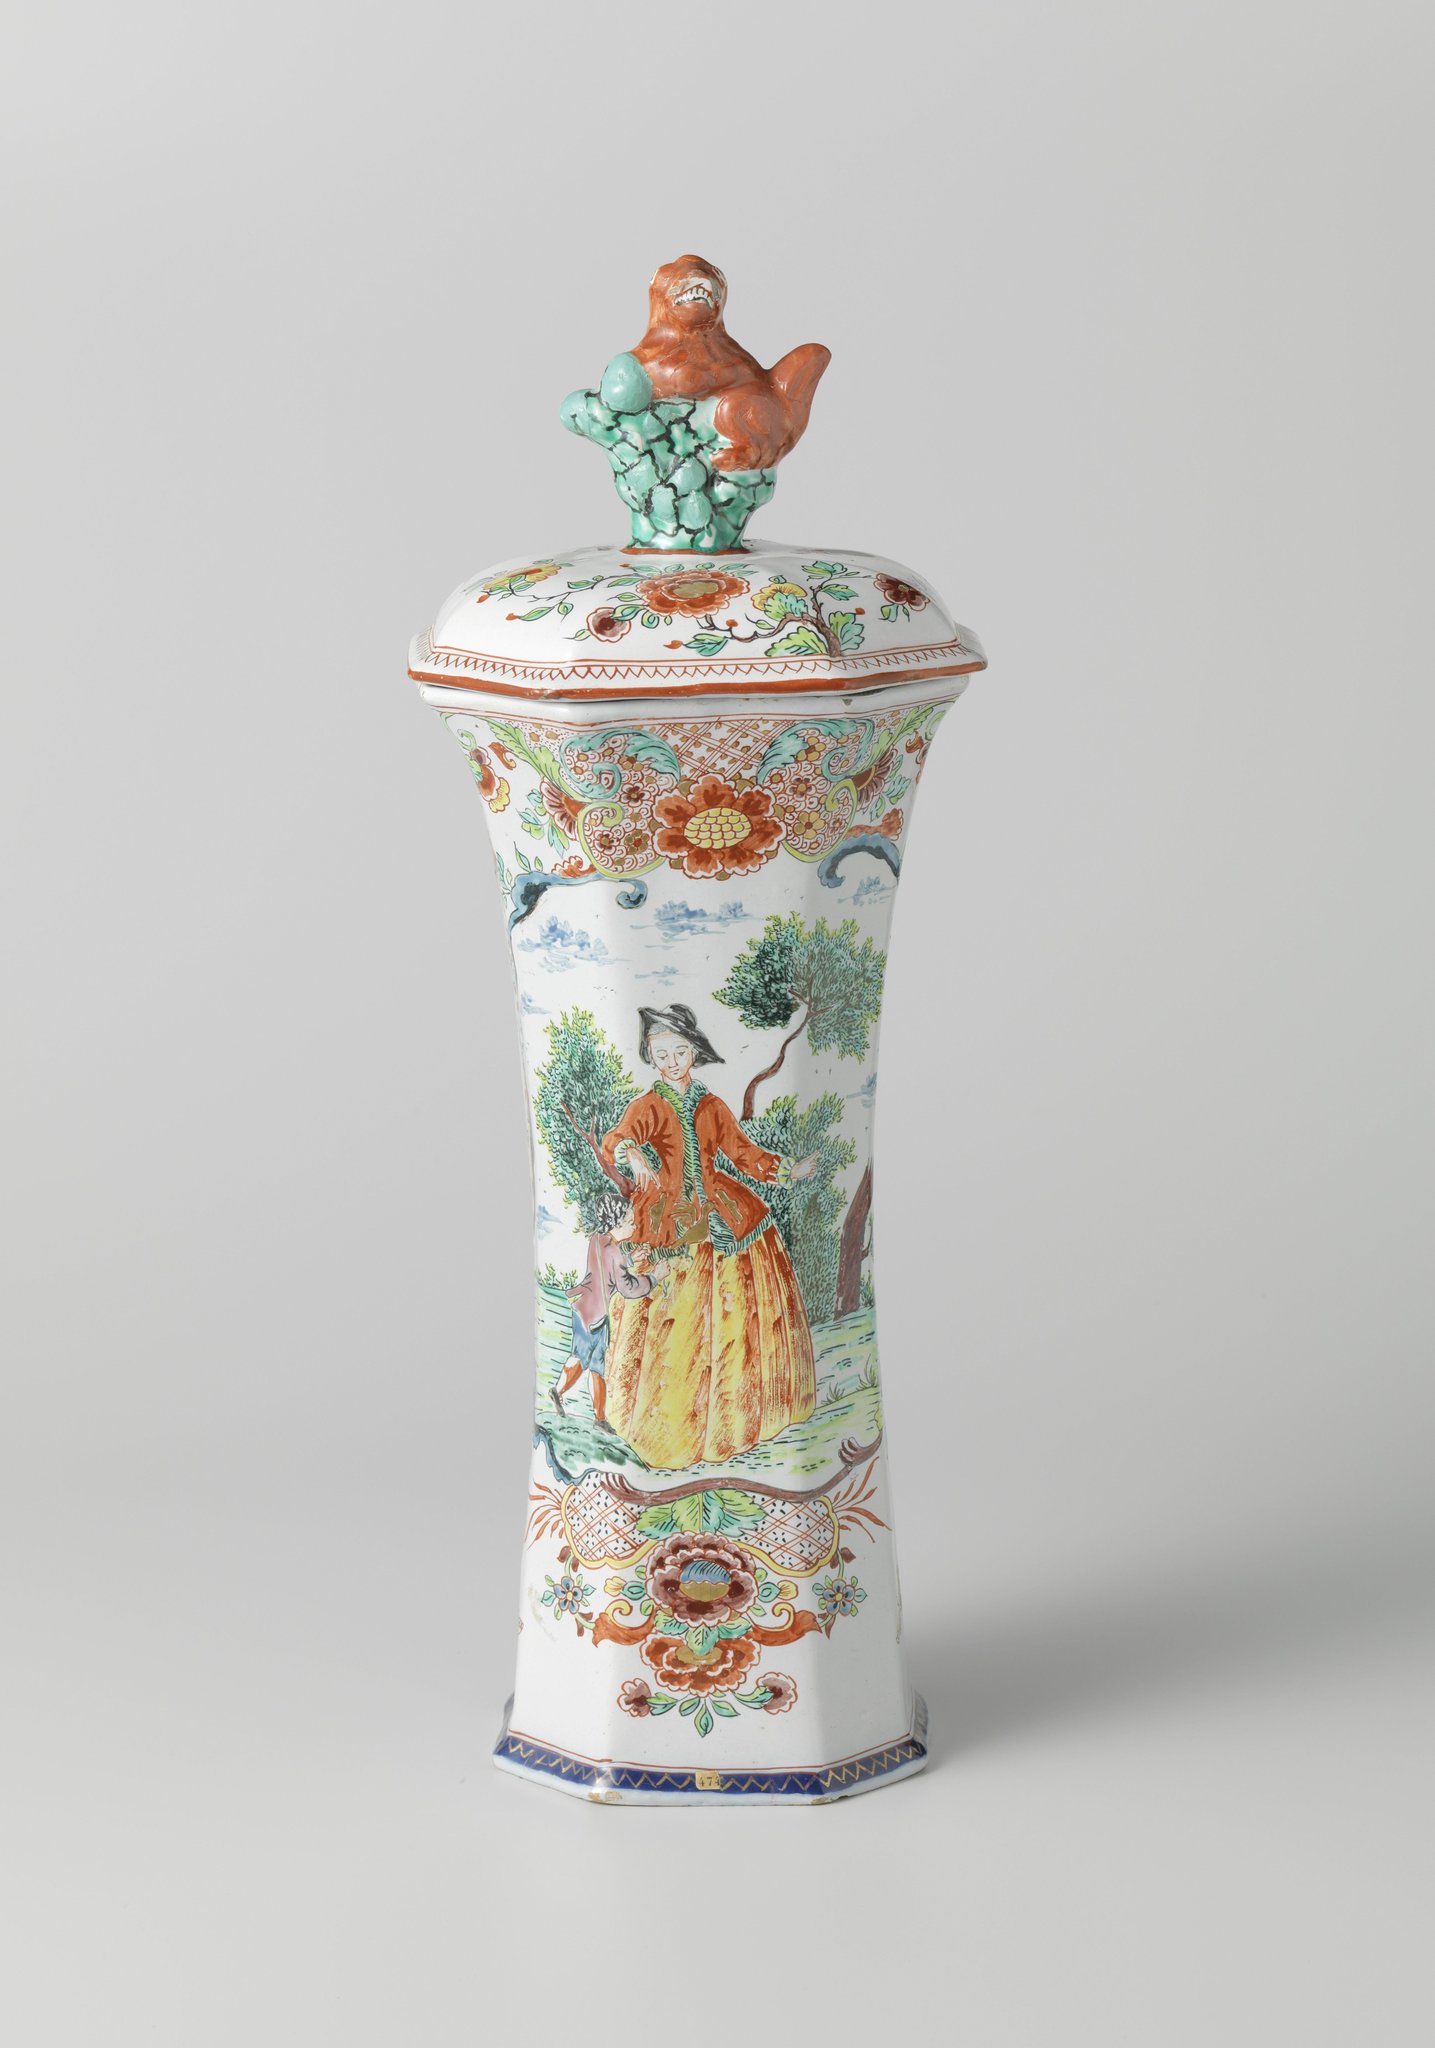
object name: bekervaas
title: Bekervaas, onderdeel van een kaststel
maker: Anonymous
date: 1740-1760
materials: faience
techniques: kiln, painted, polychromy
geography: delft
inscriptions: collector's mark: ‘collection J.F. Loudon’, inscription: ‘les 3 jun?’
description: Beker van faïence. De buik veelkleurig beschilderd met een vrouw met kind omgeven door bloemtakken. De knop van het deksel wordt gevormd door een Fo' leeuw. De beker behoort tot een vijfdelig kaststel bestaande uit drie dekselvazen en twee bekers met deksels.